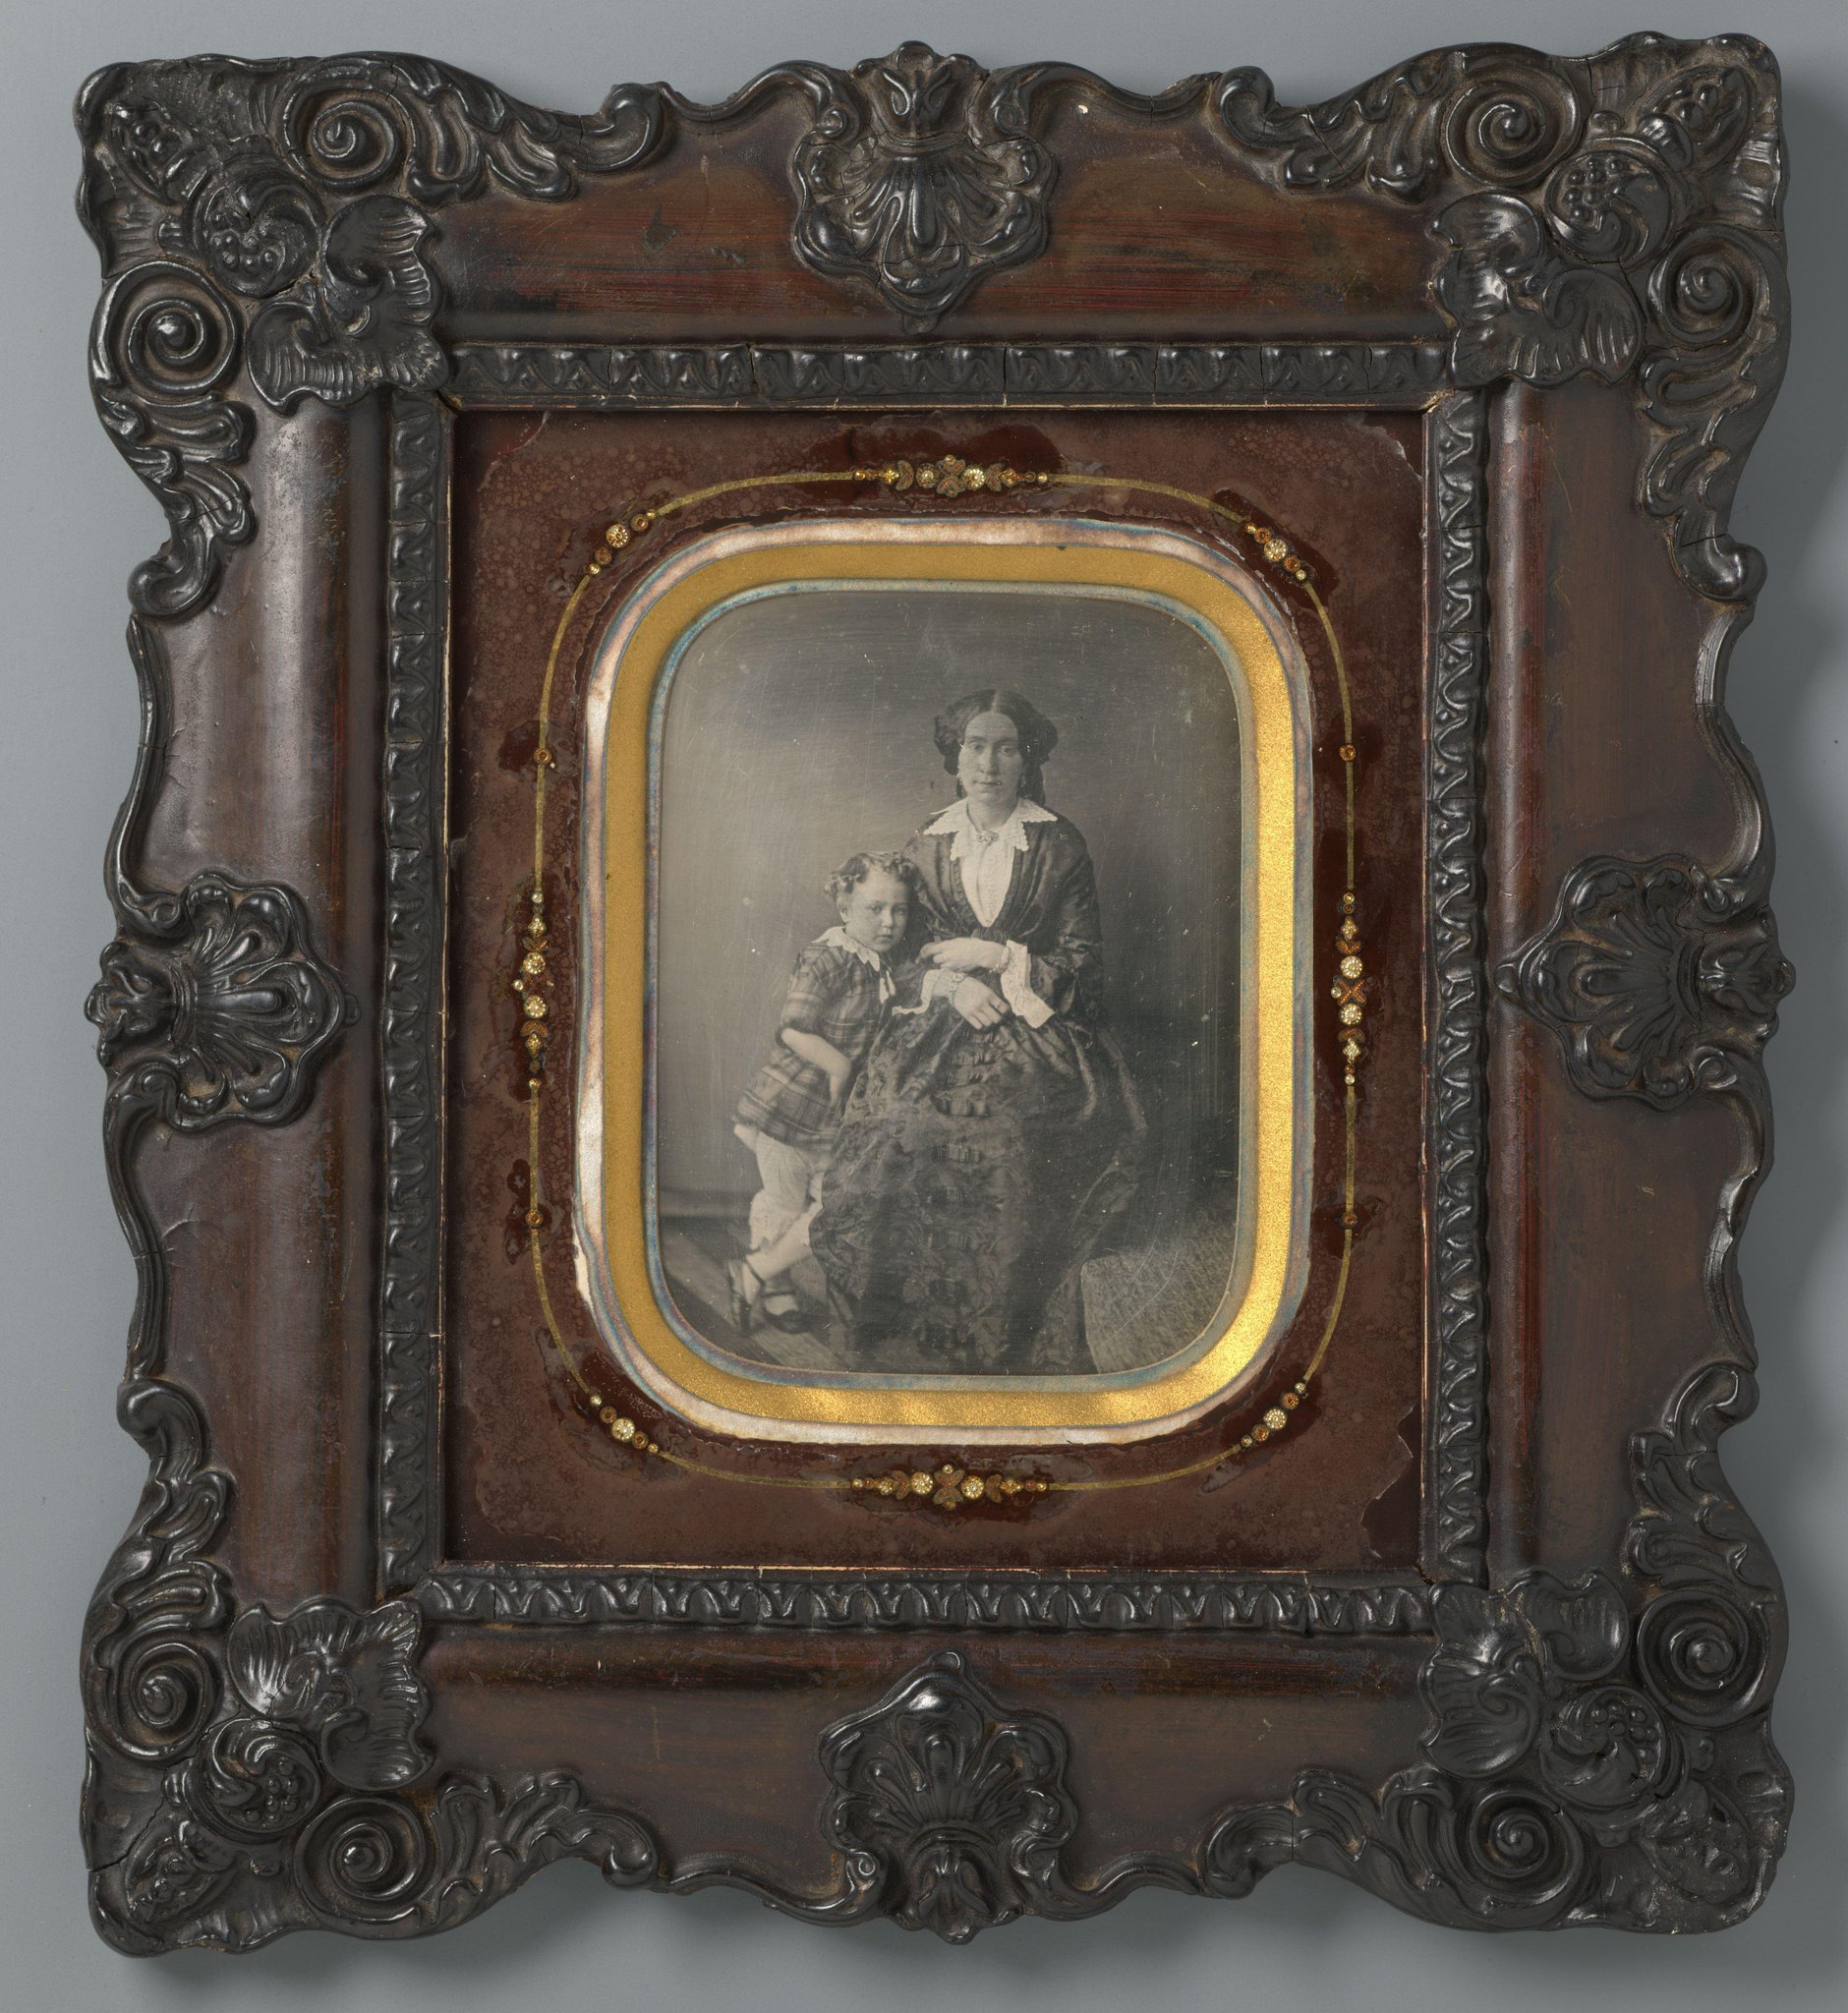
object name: photograph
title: Portret van een onbekende moeder en kind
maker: Anonymous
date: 1840-1860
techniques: daguerreotype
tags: historical persons, mother and baby or young child